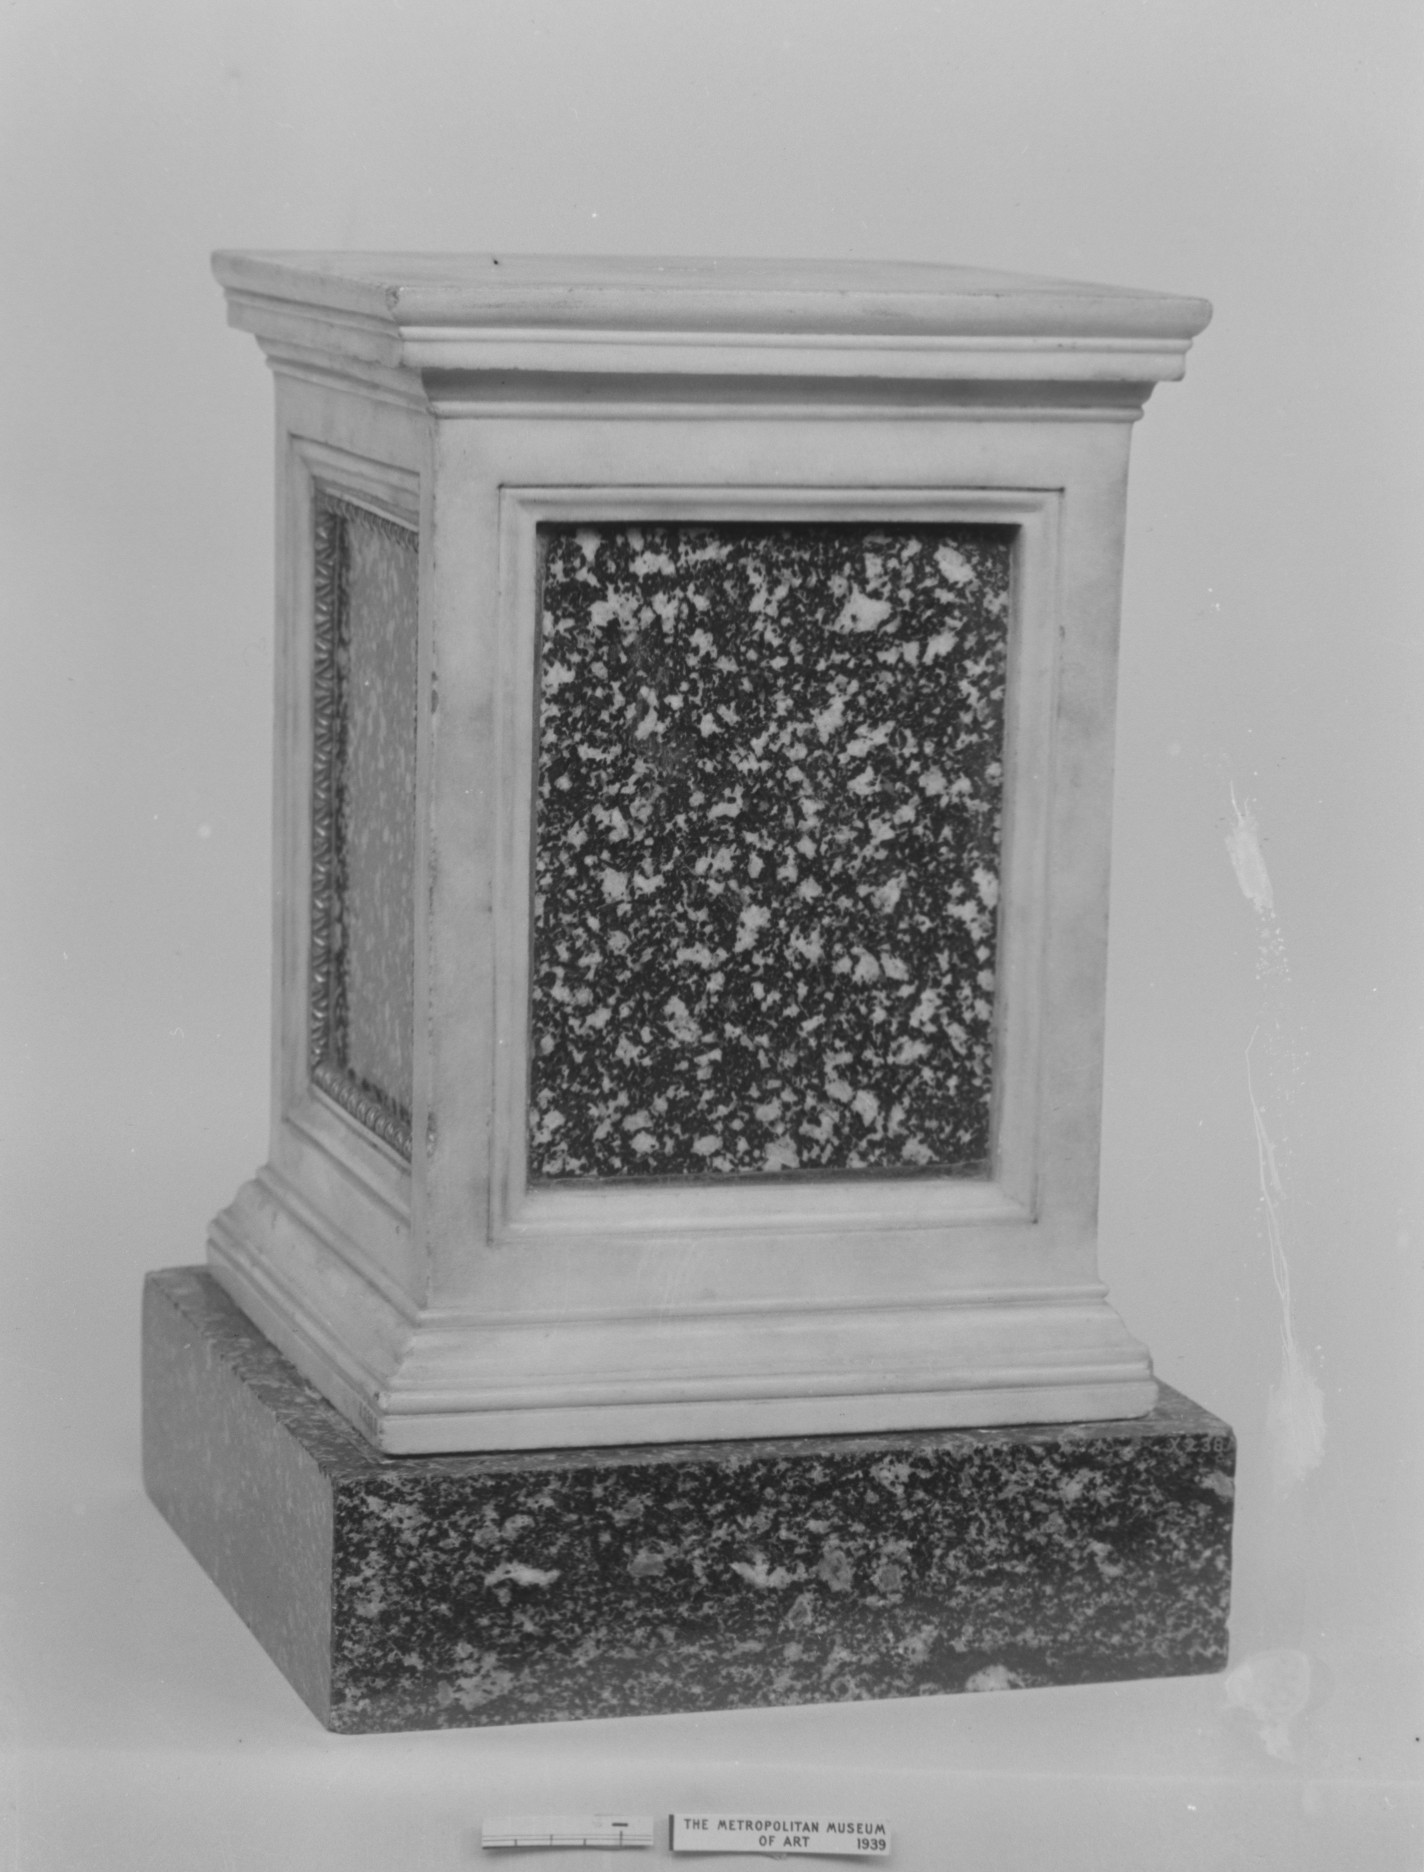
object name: pedestal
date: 1767-1833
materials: gilt bronze, marble